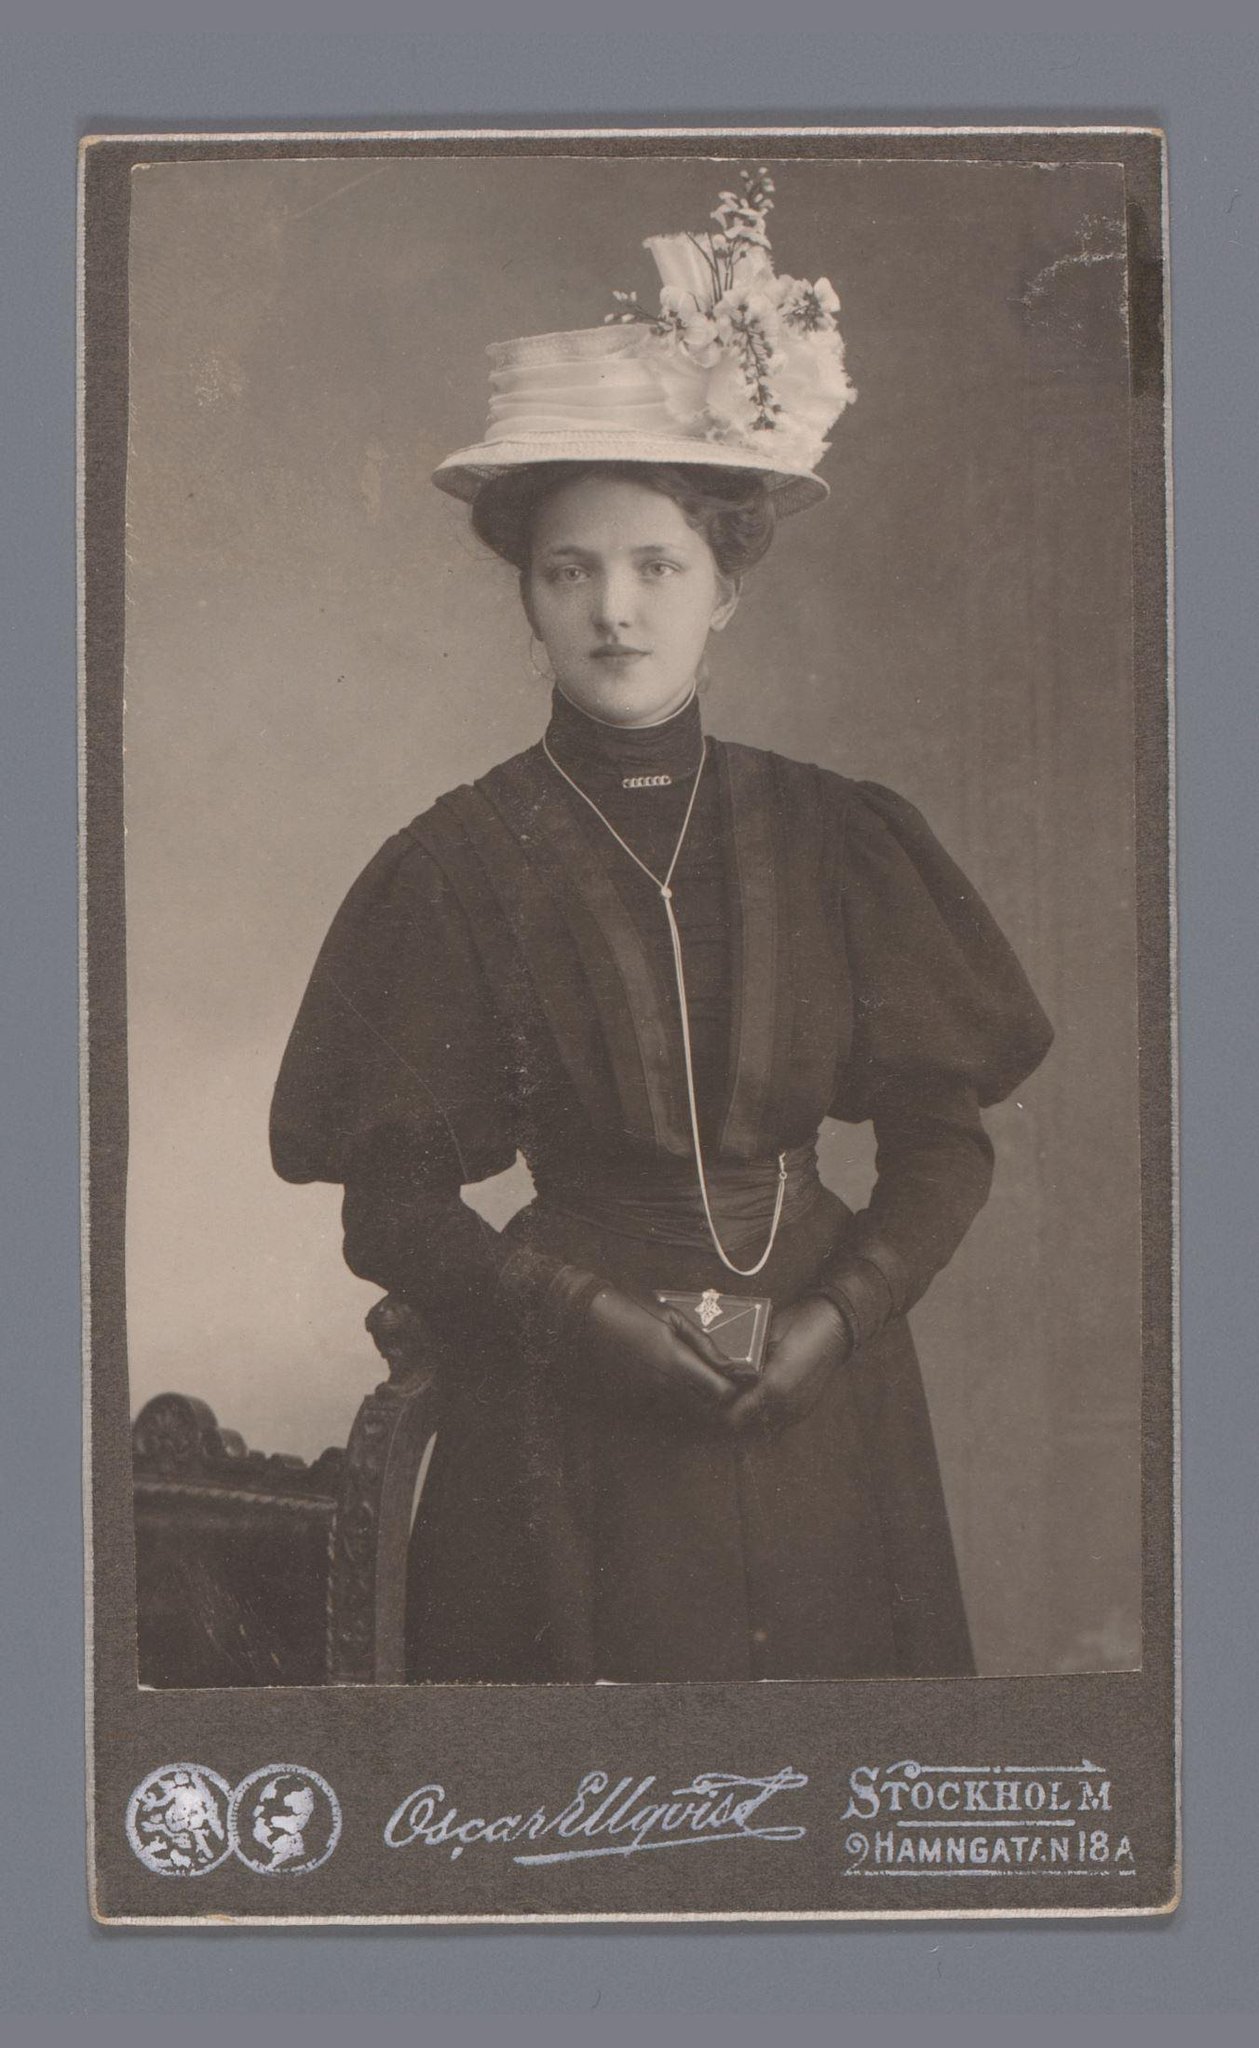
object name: photograph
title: Portret van een onbekende vrouw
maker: oscar ellquist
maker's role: fotograaf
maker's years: 1867-1937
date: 1897-1915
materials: cardboard, photographic support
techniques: gelatin silver print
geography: stockholm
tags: adolescent, young woman, maiden, historical persons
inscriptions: inscription: ‘OSCAR ELLQVIST/ STOCKHOLM/ HAMNGATAN 18A./ SVEASALEN./ ALLM. TELEFON 131./ PRISBELÖNT i/ STOCKHOLM 1897.’, address: ‘STOCKHOLM/ HAMNGATAN 18A’